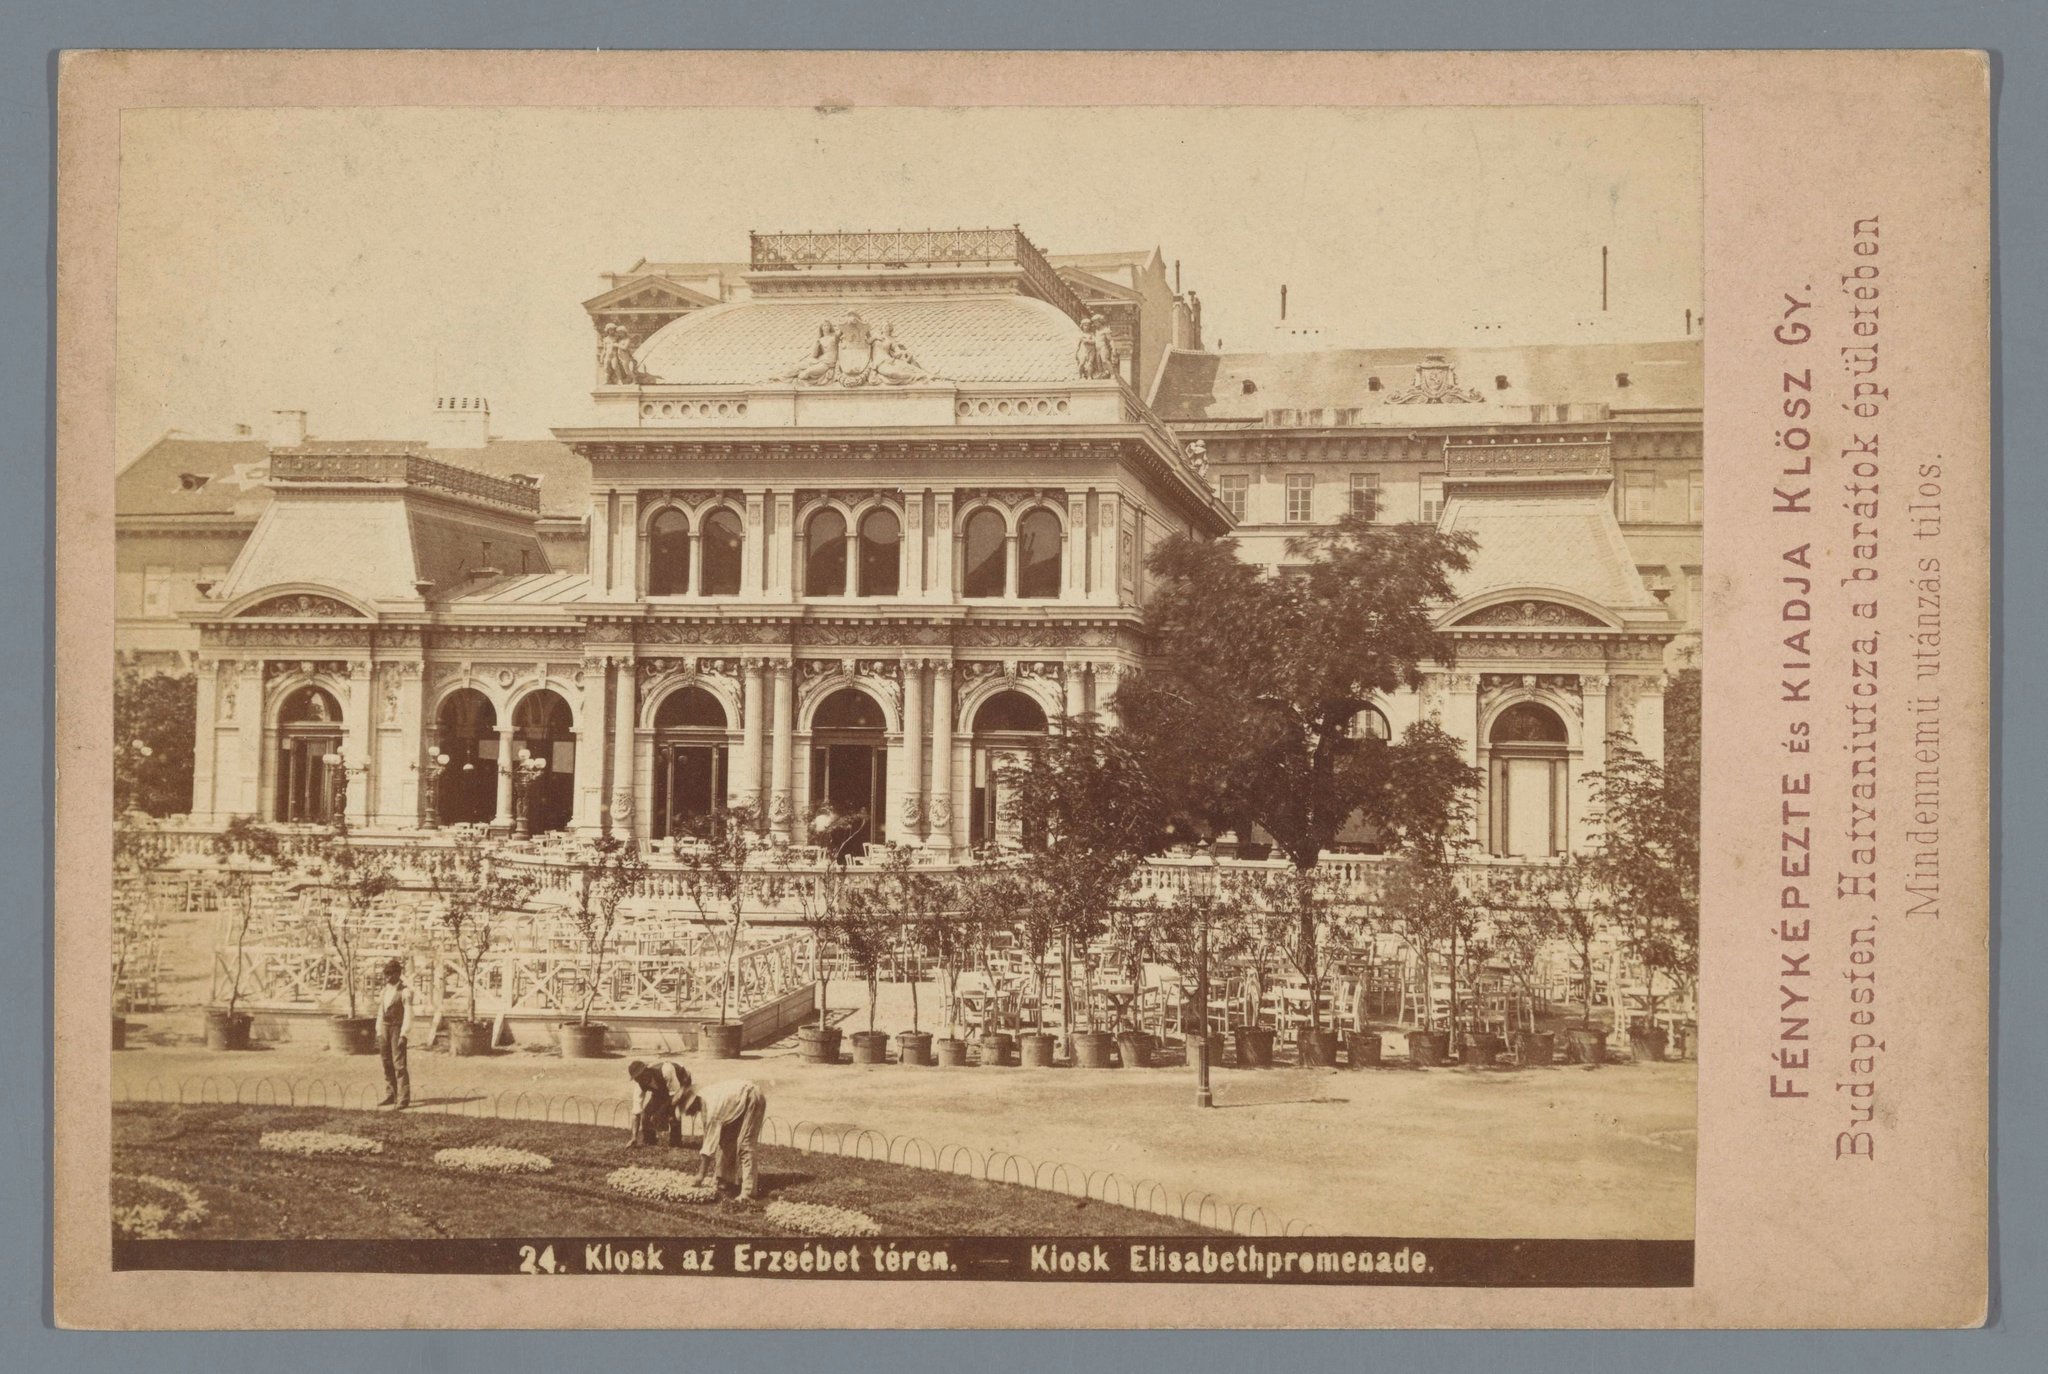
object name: cabinet photograph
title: Gezicht op de Elisabethpromenade in Boedapest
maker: klösz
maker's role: fotograaf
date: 1850-1900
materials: cardboard, photographic support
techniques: albumen print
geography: budapest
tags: avenue, boulevard, promenade, esplanade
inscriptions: retailer's mark: ‘8. Wácziutcza 8/ Hatschek Miksa/ Opticus, Budapest/ 8 Waitzstrasse 8’, number: ‘50’, number: ‘24’, address: ‘Fényképezte és Kiadja Klösz Gy./ Budapesten, Hatvaniucza, a barátok épületében/ Mindennemü utánzás tilos.’